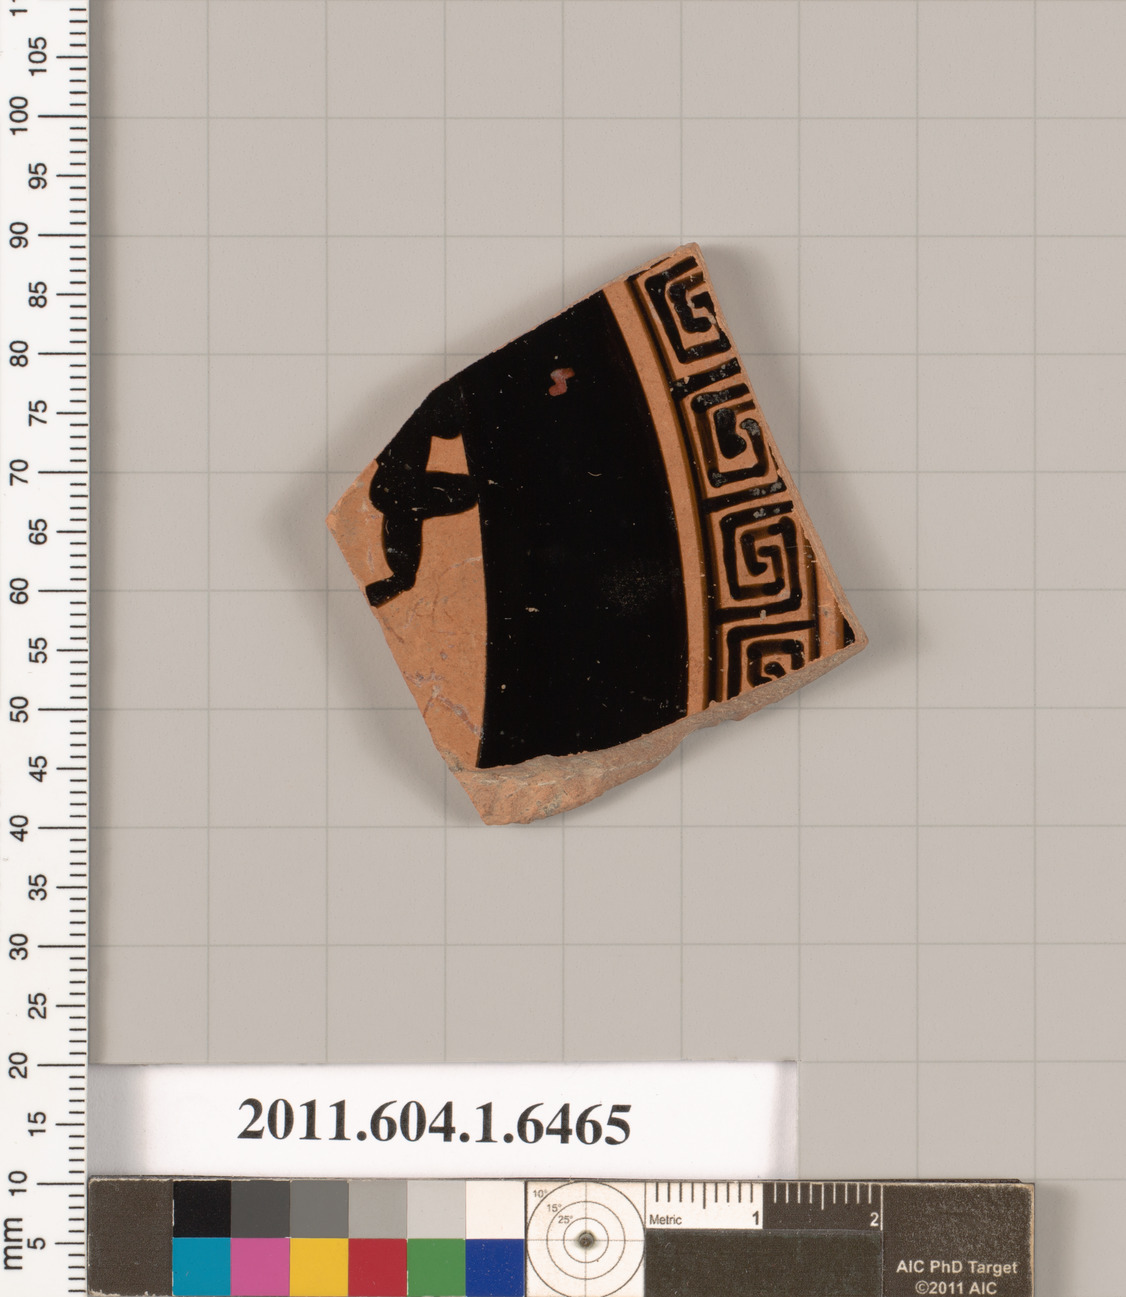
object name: kylix fragment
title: Terracotta fragment of a kylix (drinking cup)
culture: greek, attic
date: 490-480 BCE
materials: terracotta